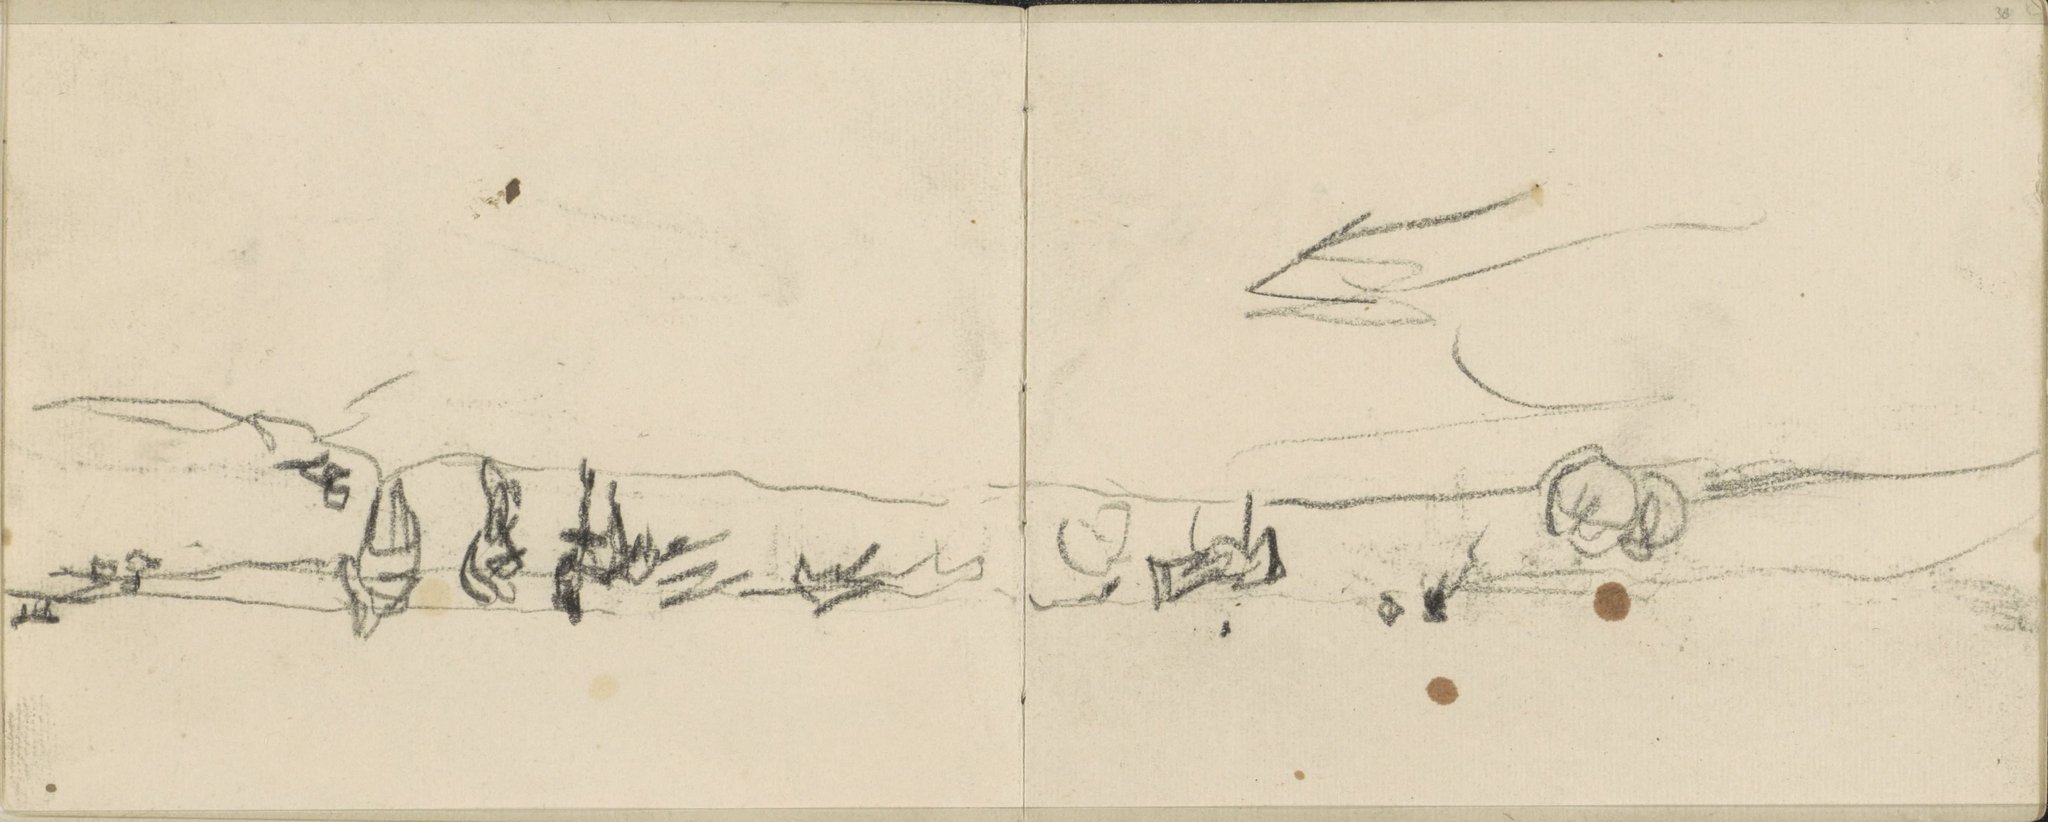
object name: sketchbook leaf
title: Cavalerist met paarden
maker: george hendrik breitner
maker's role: draughtsman, painter, print maker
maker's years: 1857-1923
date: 1893-1899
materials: chalk, paper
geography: amsterdam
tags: landscapes, horse, the soldier; the soldier's life (+ cavalry, horsemen)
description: Pagina 37 en pagina 38 uit een schetsboek met 28 bladen.